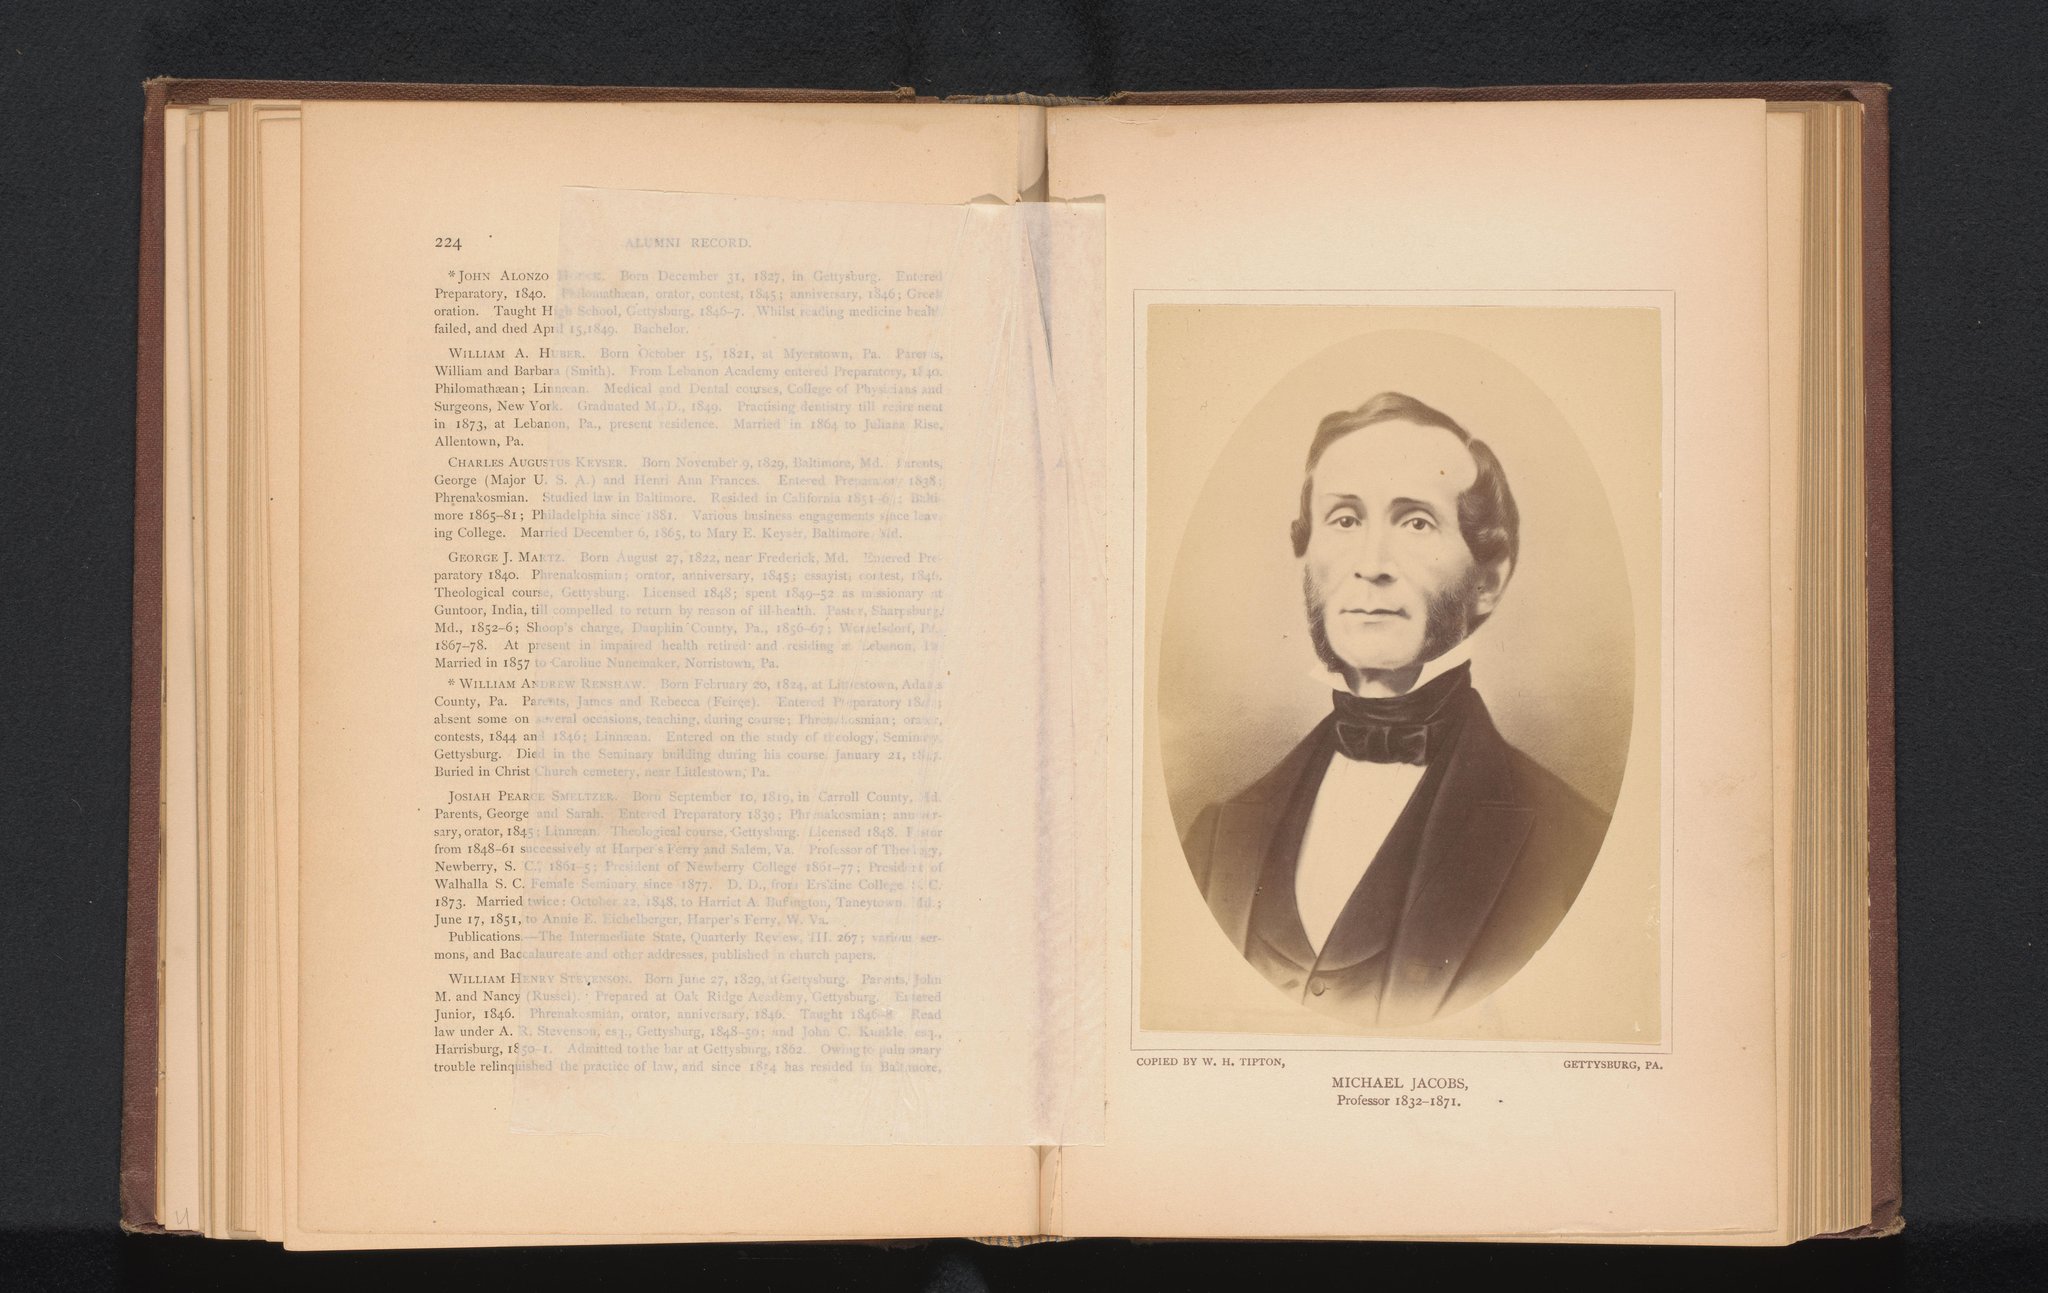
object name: page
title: Michael Jacobs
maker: william h. tipton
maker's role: fotograaf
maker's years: 1850-1920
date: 1877-1882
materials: photographic support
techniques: albumen print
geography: gettysburg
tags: professor